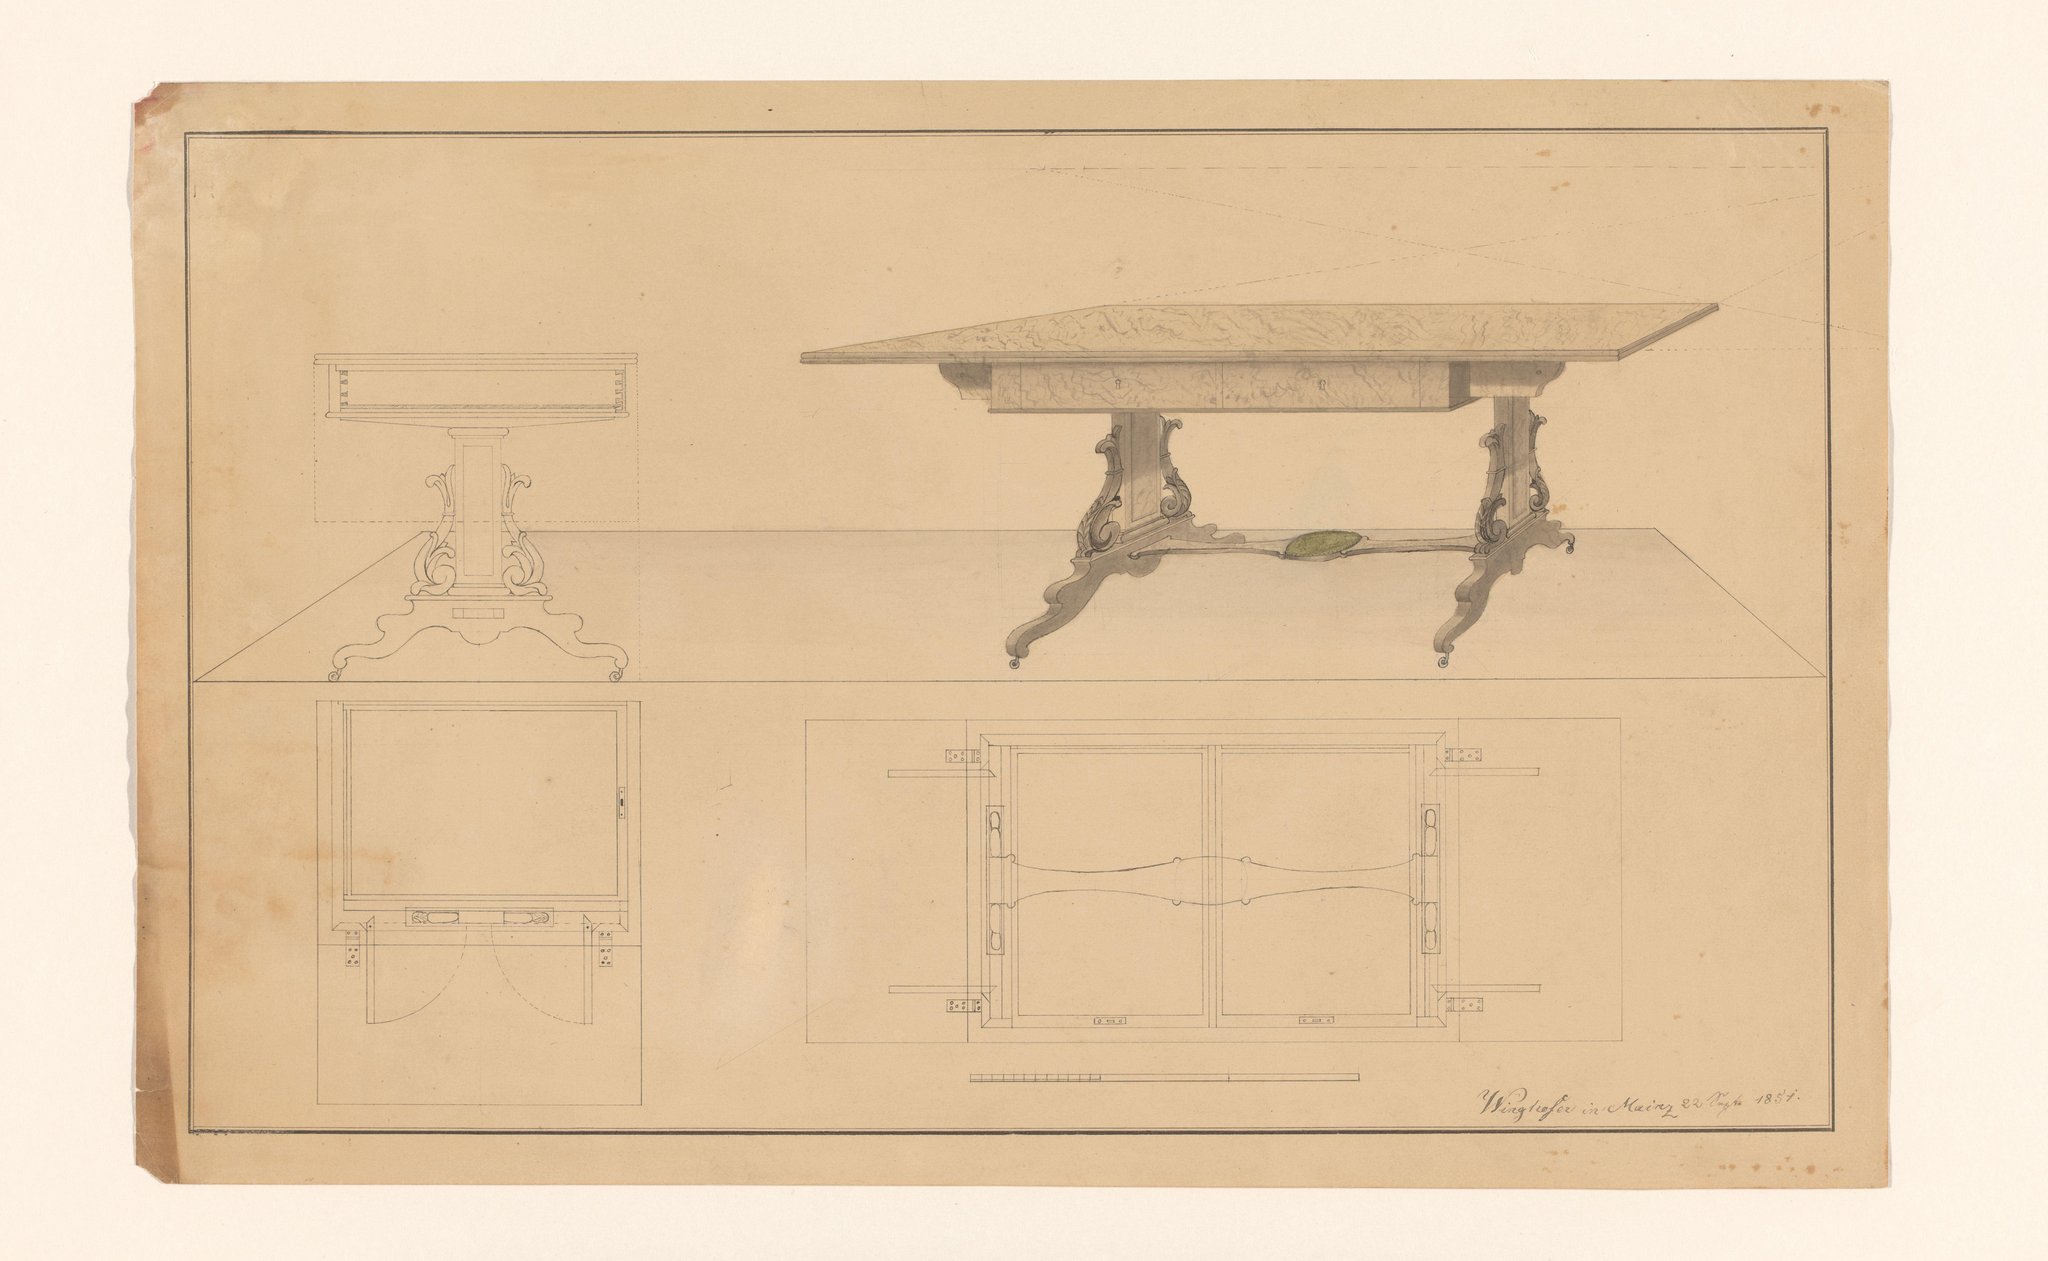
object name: drawing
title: Ontwerp voor een uitklaptafel met zijaanzicht en plattegronden onder beide aanzichten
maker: b. winghofer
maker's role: draughtsman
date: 1851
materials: graphite, ink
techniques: drawing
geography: mainz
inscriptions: signature and date: ‘Winghofer in Mainz 22 Sept. 1851’, size: ‘maatstaf’